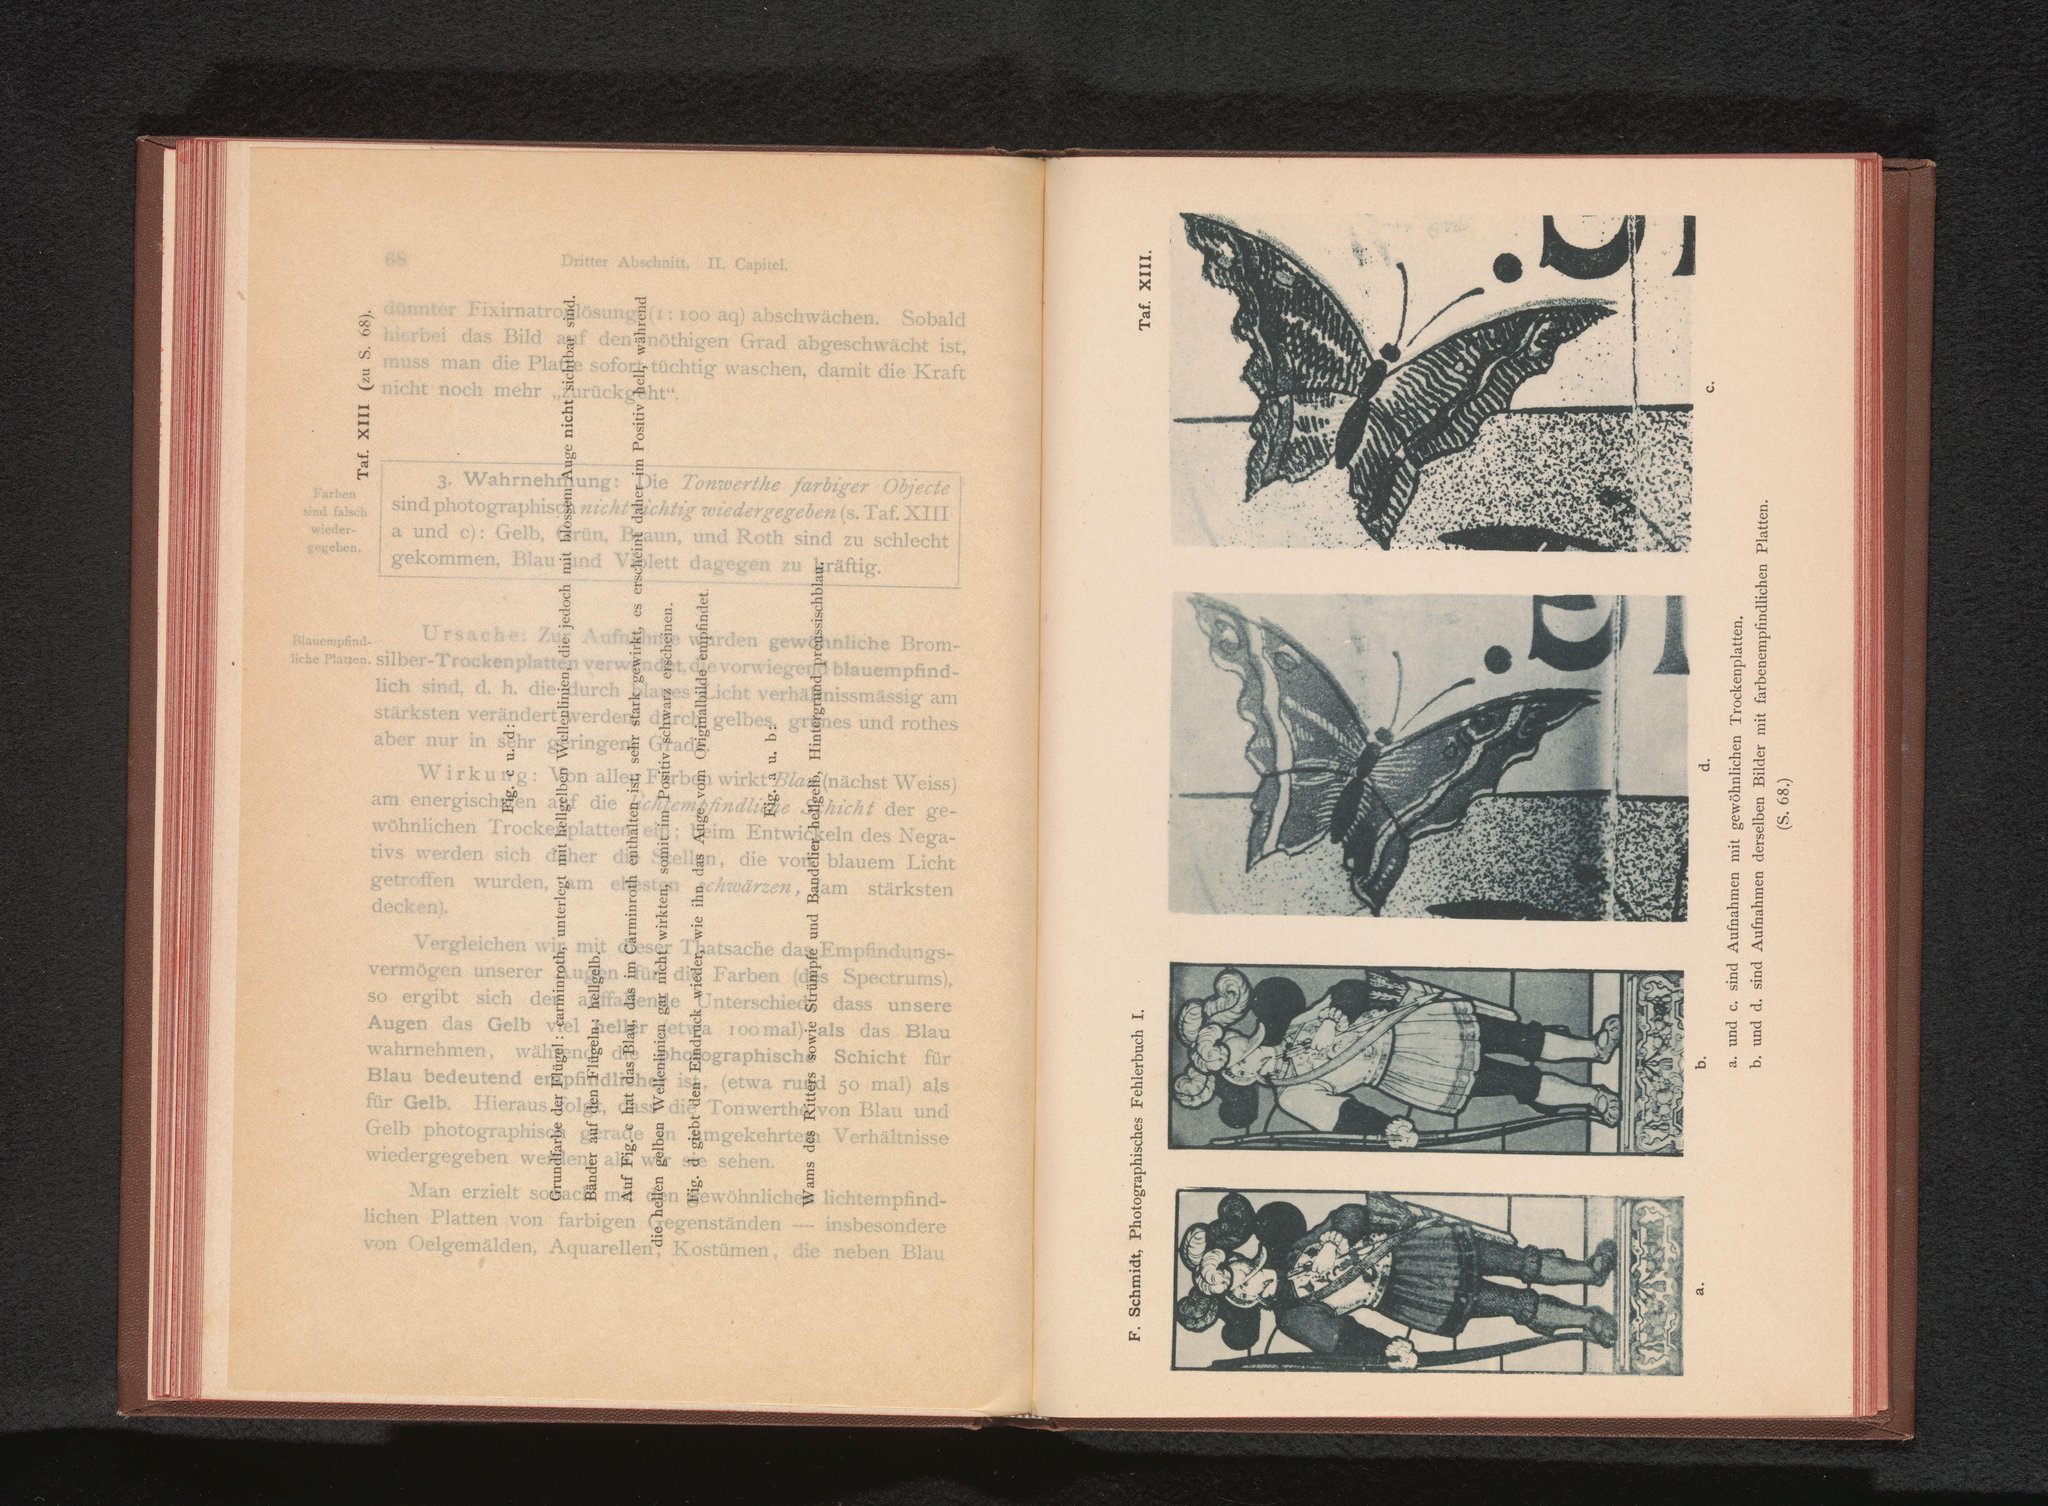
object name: page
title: Twee voorbeelden van resultaten met gewone fotografische platen en twee voorbeelden van dezelfde opnamen op kleurgevoelige platen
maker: Anonymous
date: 1890-1895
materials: paper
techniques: photograph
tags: adult man, insects: butterfly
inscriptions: inscription: ‘a. b. d. c./ a. und c. sind Aufnahmen mit gewöhnlichen Trockenplatten./ b. und d. sind Aufnahmen derselben Bilder mit farbenempfindlichen Platten./ (S. 68.)’, number: ‘Taf. XIII.’